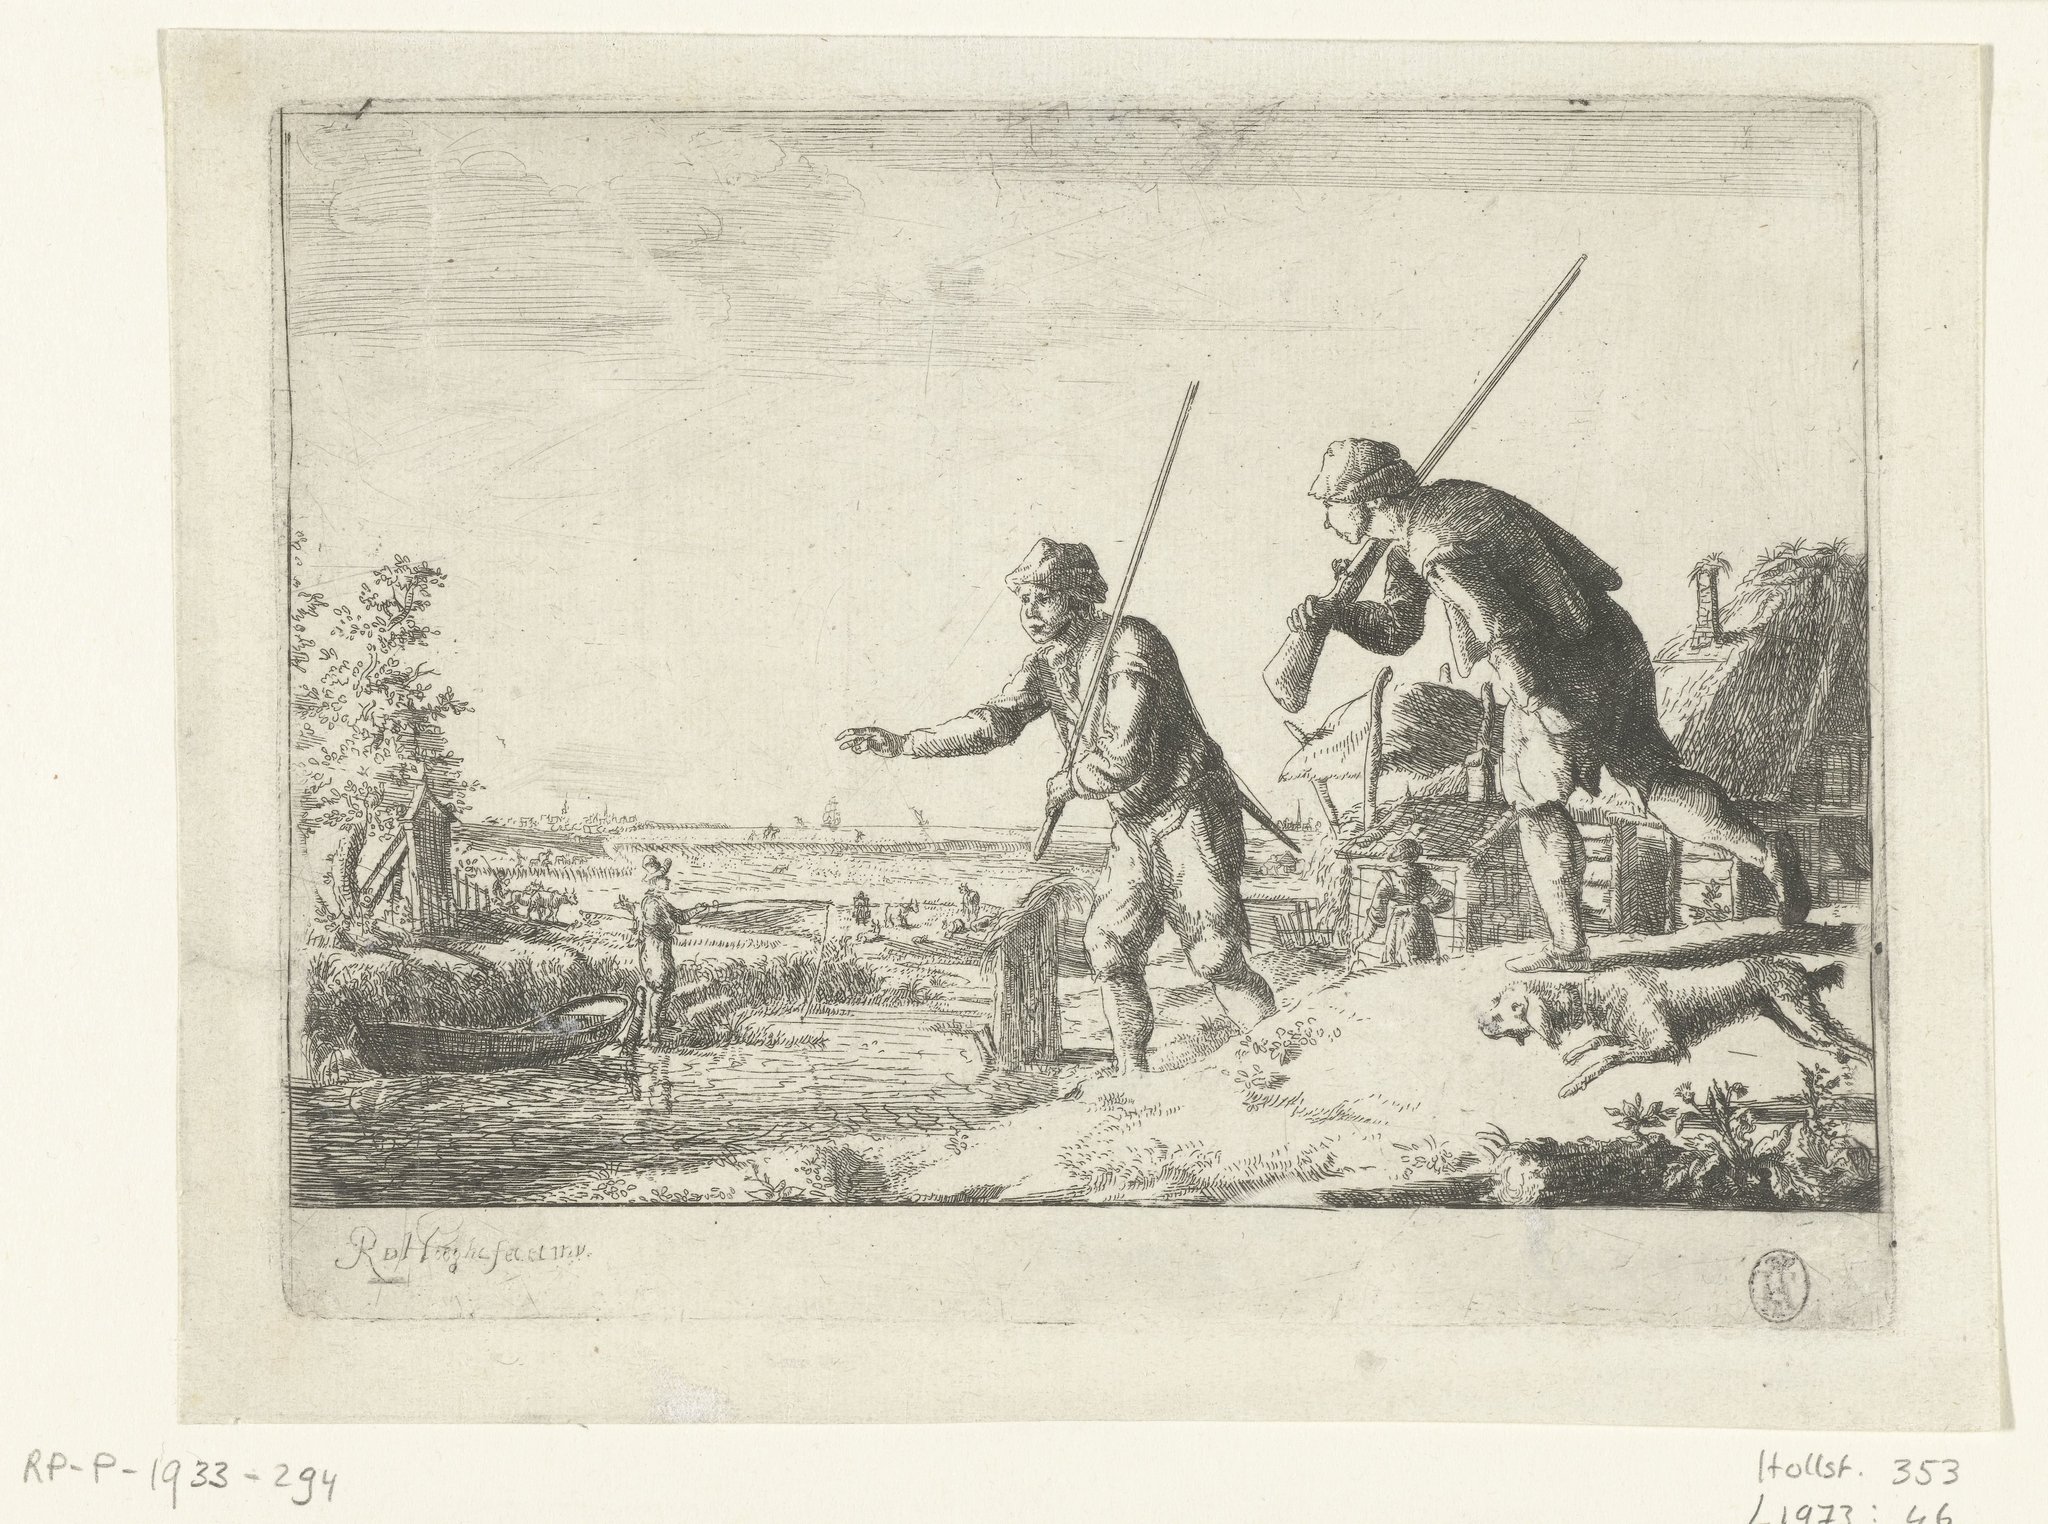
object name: print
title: Twee soldaten bij de over van een rivier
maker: romeyn de hooghe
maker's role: draughtsman, goldsmith, painter, print maker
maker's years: 1645-1708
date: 1655-1667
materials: paper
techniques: etching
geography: netherlands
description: Twee soldaten bij de over van een rivier